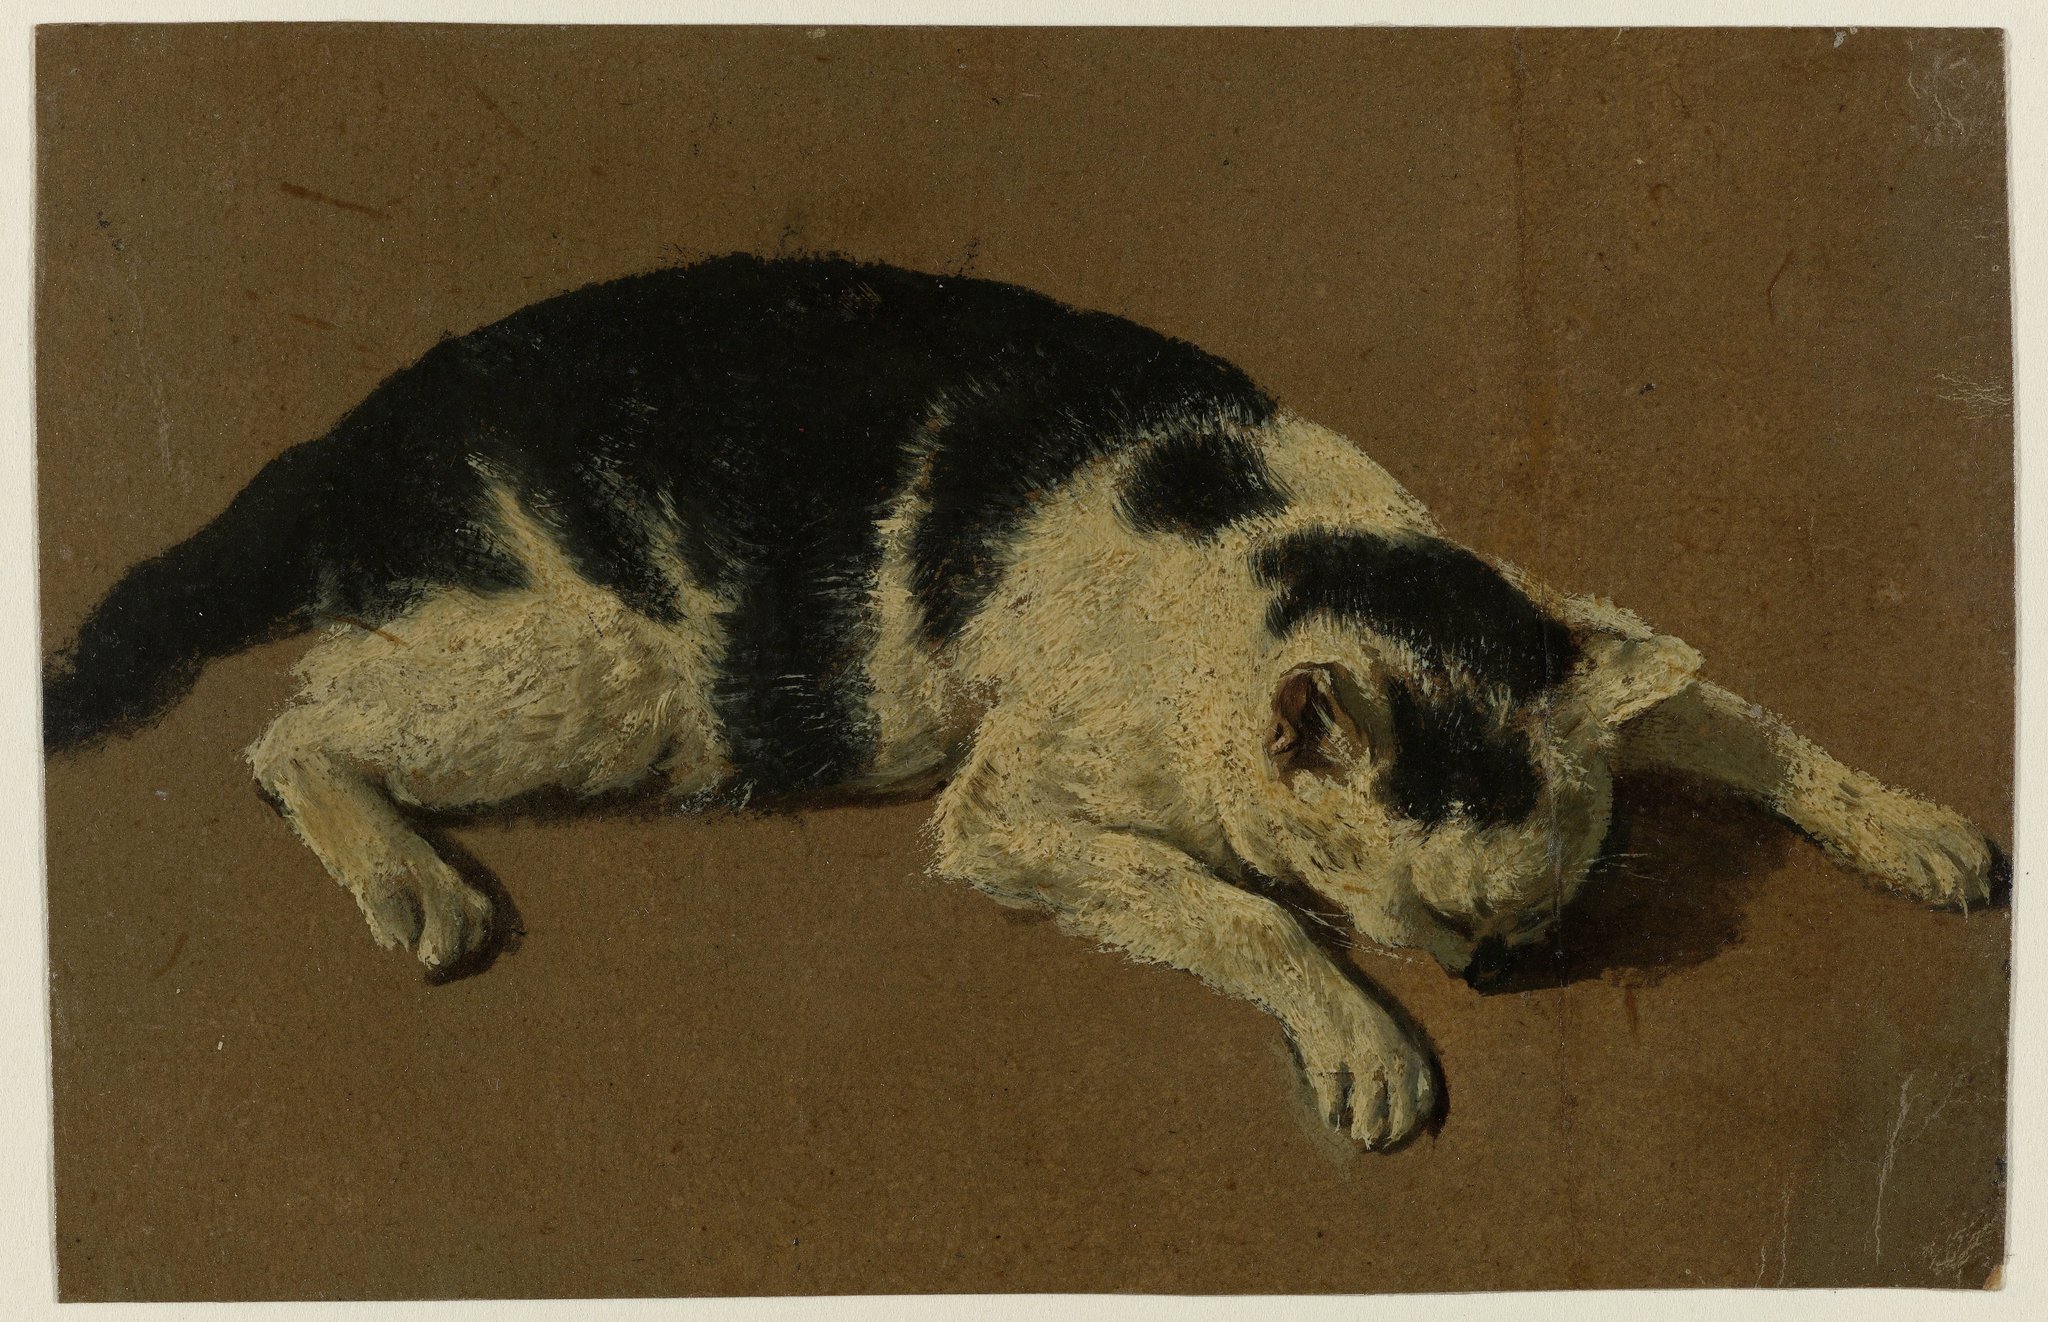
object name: drawing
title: Kat liggend met de kop tussen de voorpoten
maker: adriaen van de velde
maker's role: draughtsman, painter, print maker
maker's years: 1636-1672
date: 1646-1672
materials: oil, paper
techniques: brush, varnishing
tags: cat